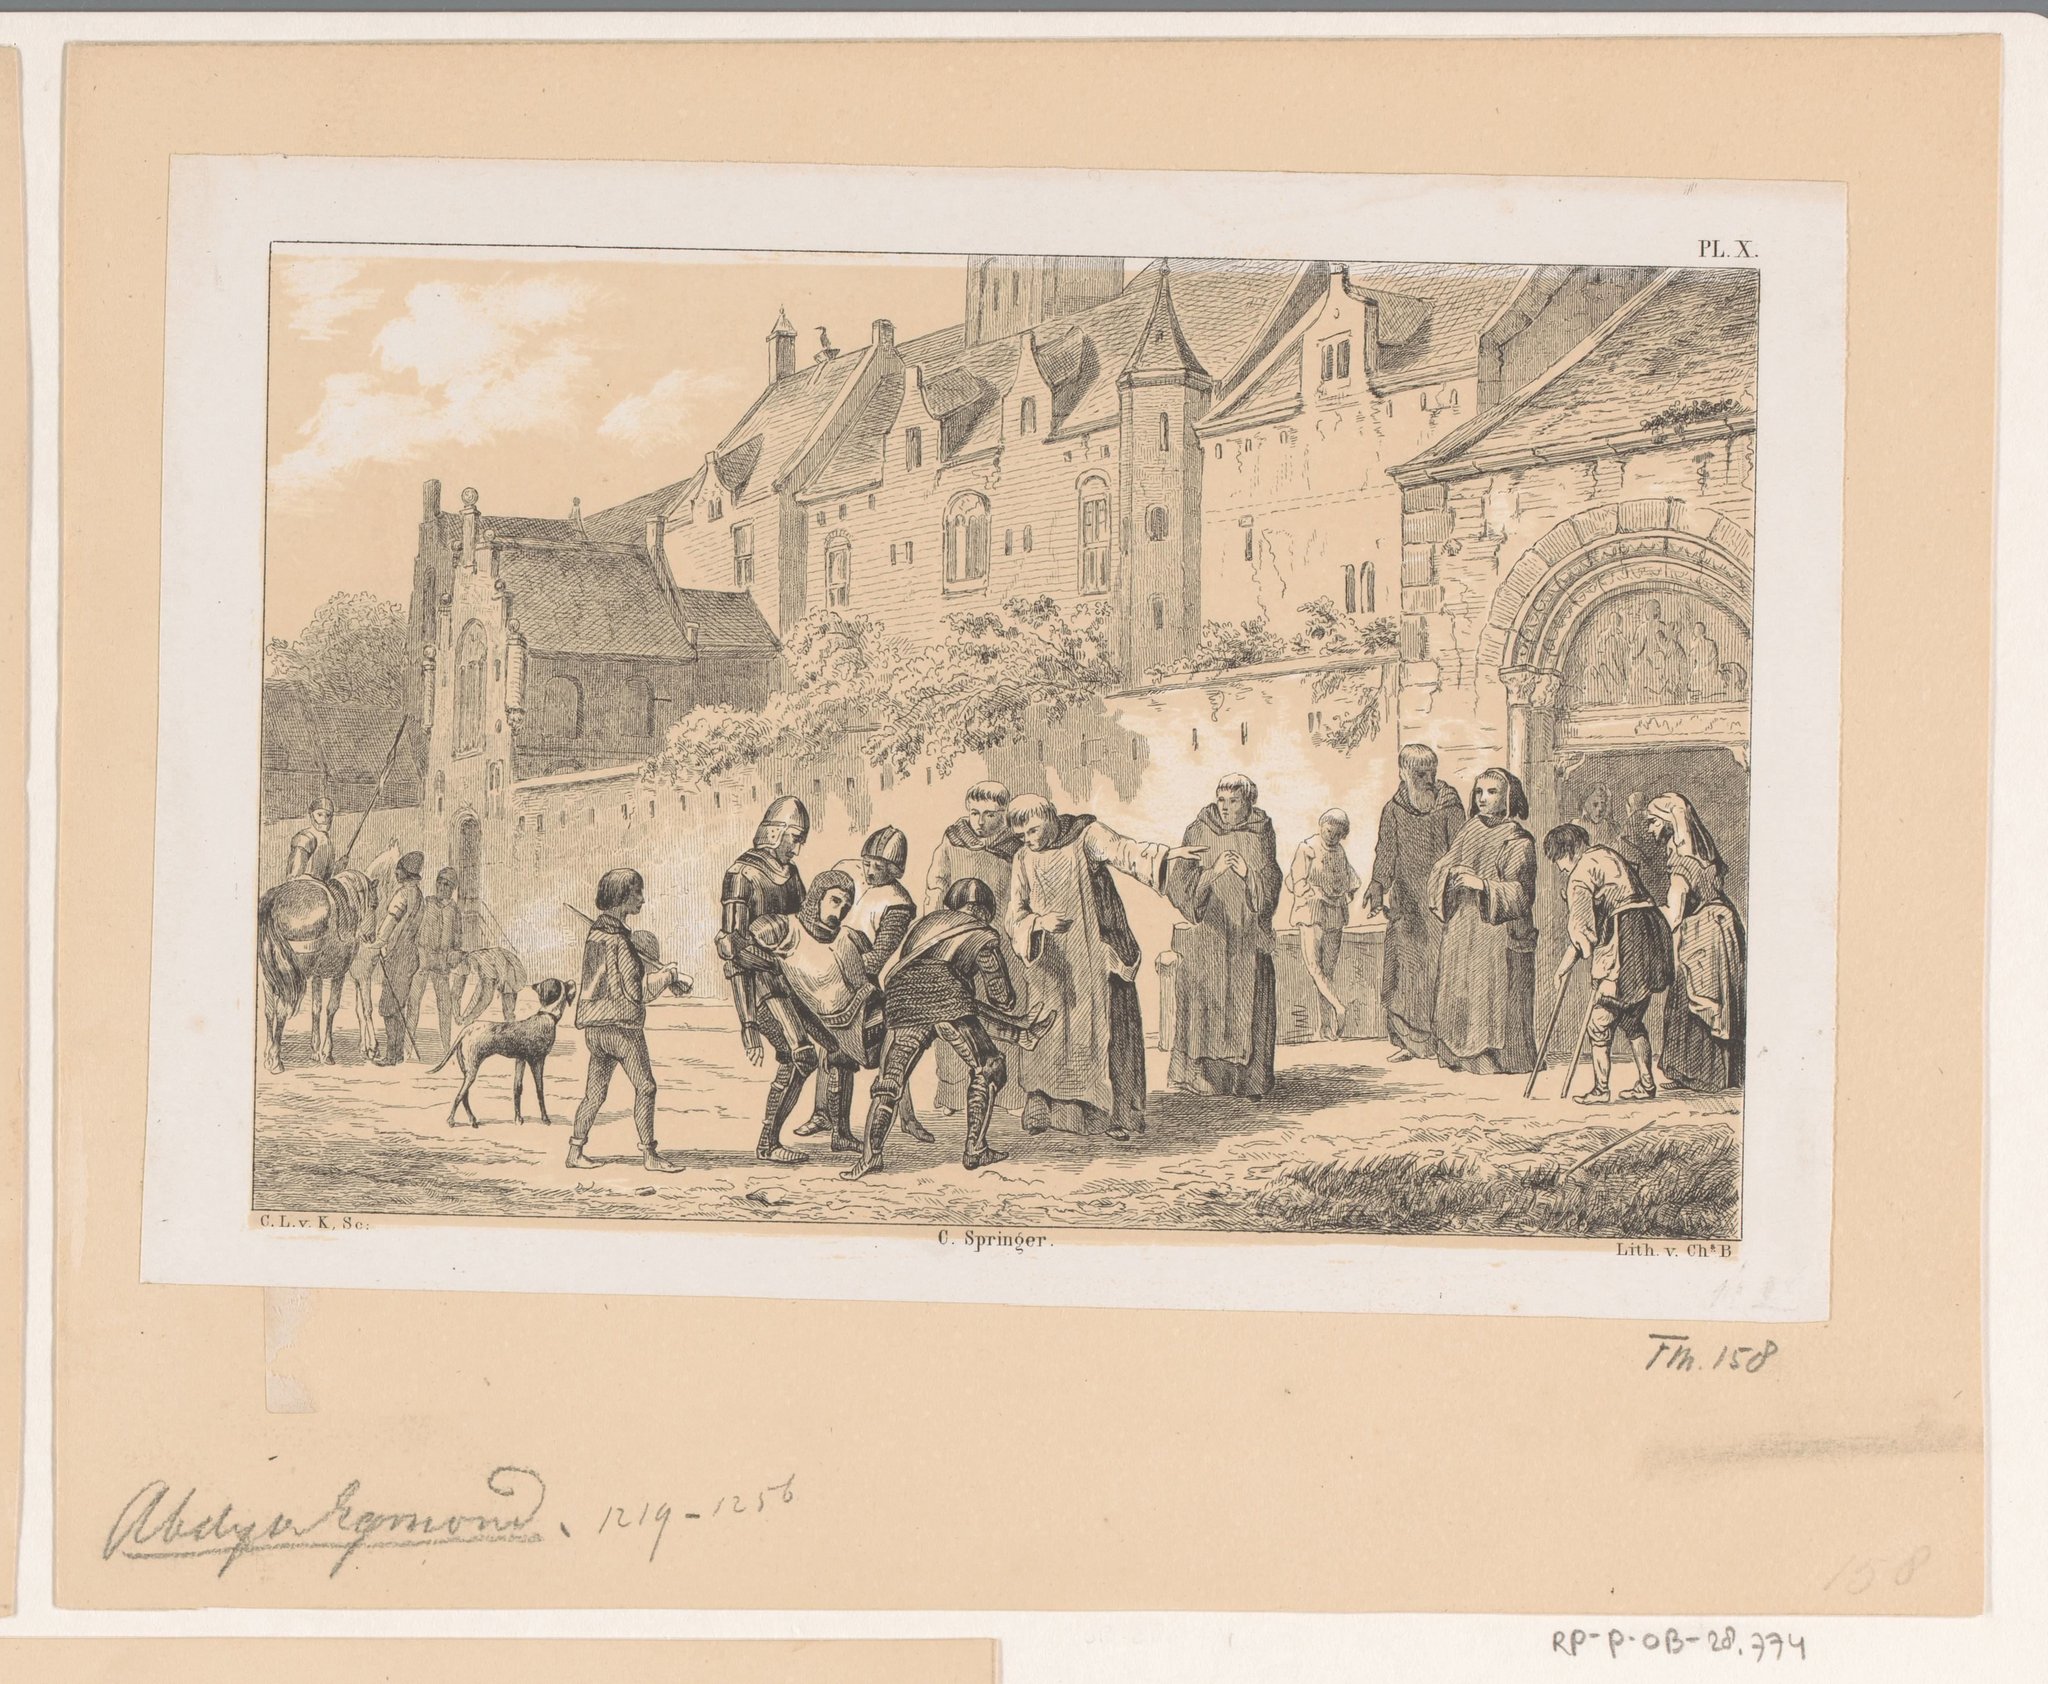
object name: print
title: Abdij van Egmond, 13e eeuw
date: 1853-1861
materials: paper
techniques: lithograph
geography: amsterdam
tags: abbey, monastery, convent ~ roman catholic church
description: Illustratie voor: Jacob van Lennep, De geschiedenis des vaderlands in schetsen en afbeeldingen, Binger, Amsterdam 1855-1861, 8 delen, pl. X.